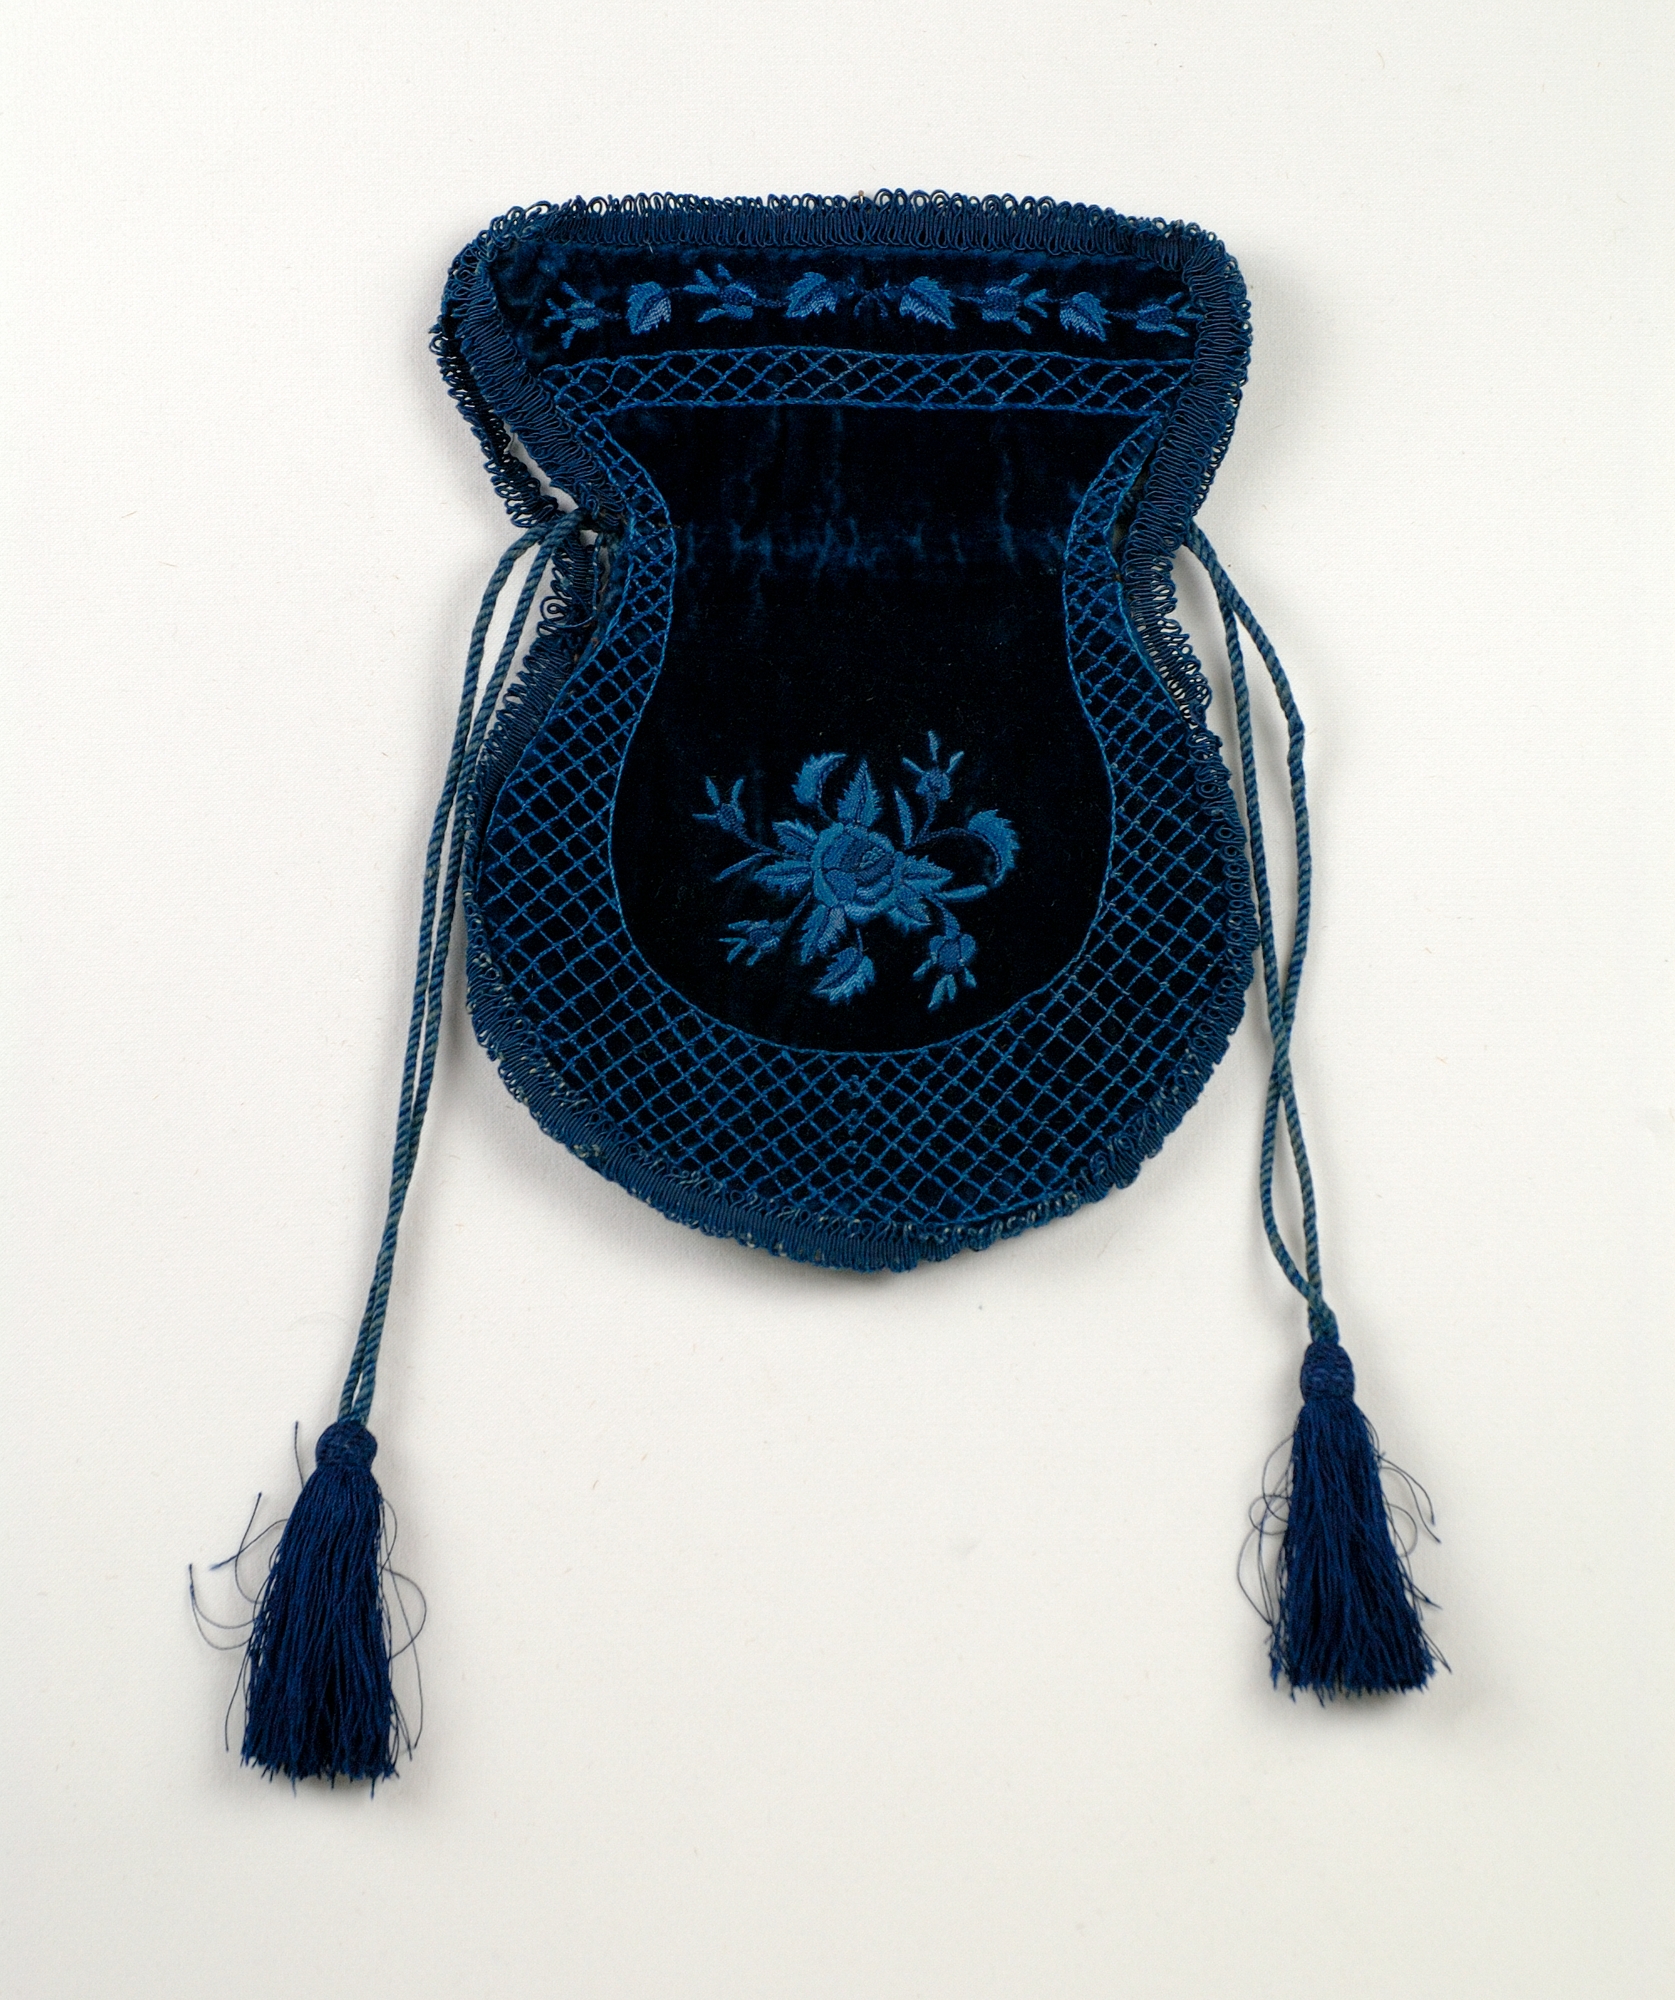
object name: pouch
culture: american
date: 1847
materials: silk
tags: flowers